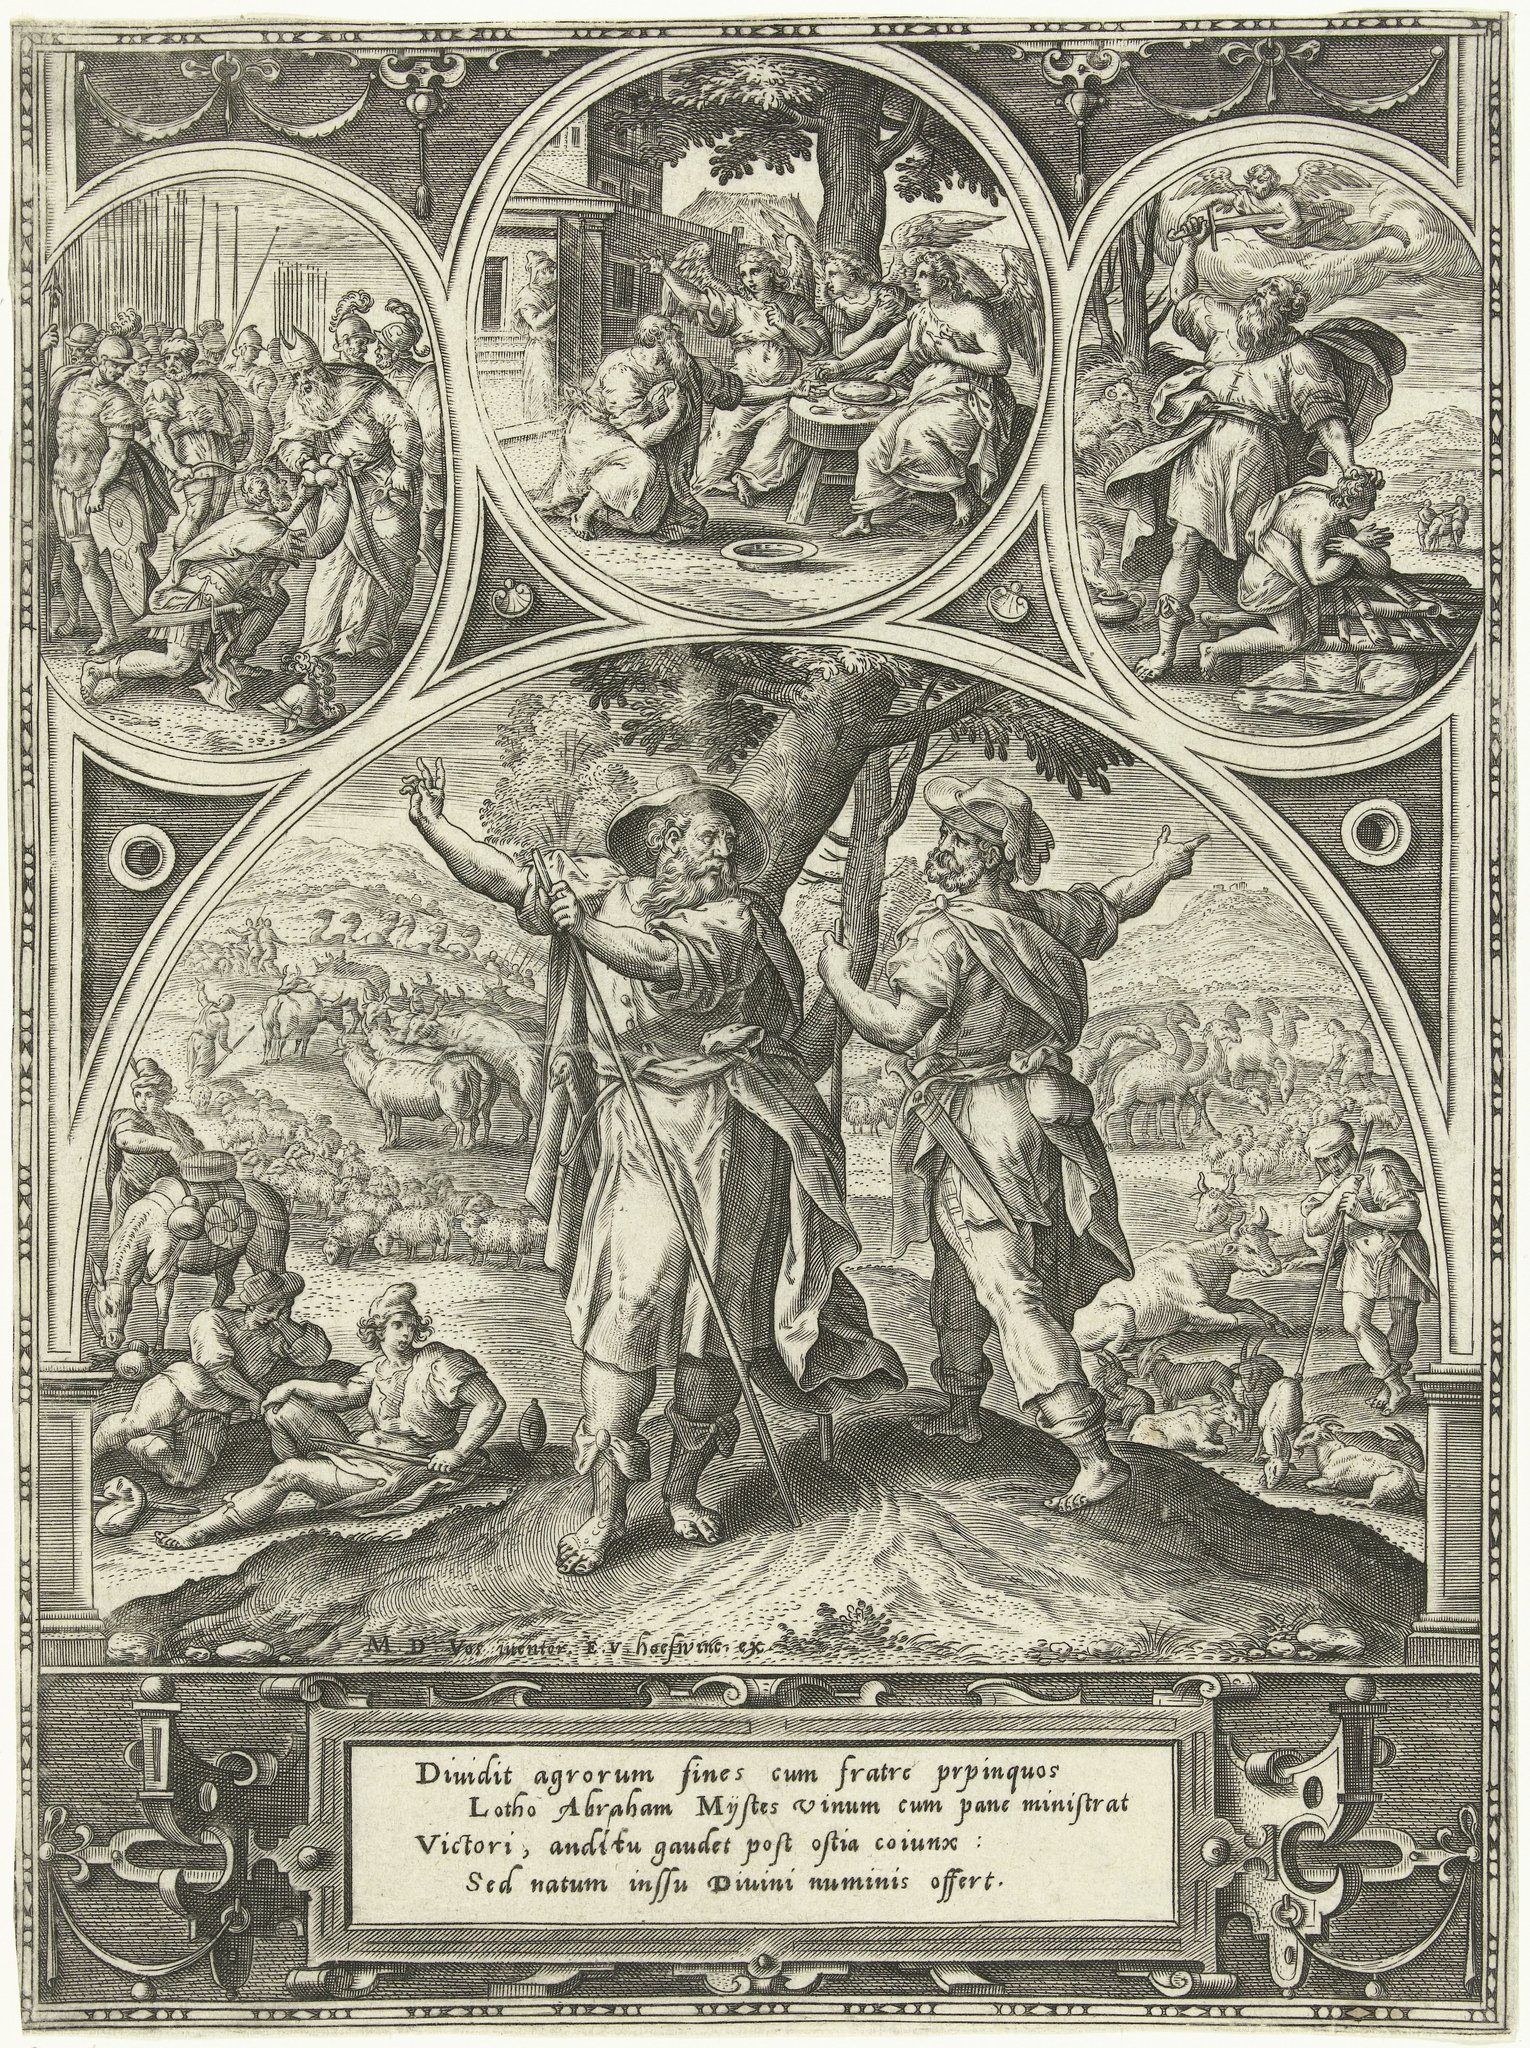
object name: print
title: Gebeurtenissen uit het leven van Abraham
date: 1579-1583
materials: paper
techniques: engraving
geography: antwerp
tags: the sacrifice of isaac (genesis 22), the visit of the three angels (three men) ~ story of abraham (genesis 18), abraham and lot separating (genesis 13), the battle of the kings and the rescue of lot (genesis 14:1-17)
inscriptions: collector's mark: Lugt 240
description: Abraham en Lot besluiten wegen te scheiden en op verschillende plaatsen een bestaan op te bouwen. Abraham neemt de gebieden aan de rechterkant, Lot de gebieden aan de linkerkant. Op de achtergrond de rijke veekuddes van Abraham en Lot. Boven, drie medaillons met afbeeldingen uit het leven van Abraham: links de ontmoeting en zegening van koning Melchisedek, midden het bezoek van drie engelen aan Abraham, rechts het offeren van Isaak aan God en een engel die Abraham tegenhoudt. De prent heeft een Latijns onderschrift in een cartouche. De prent is deel van een serie met scènes uit het Bijbelboek Genesis.